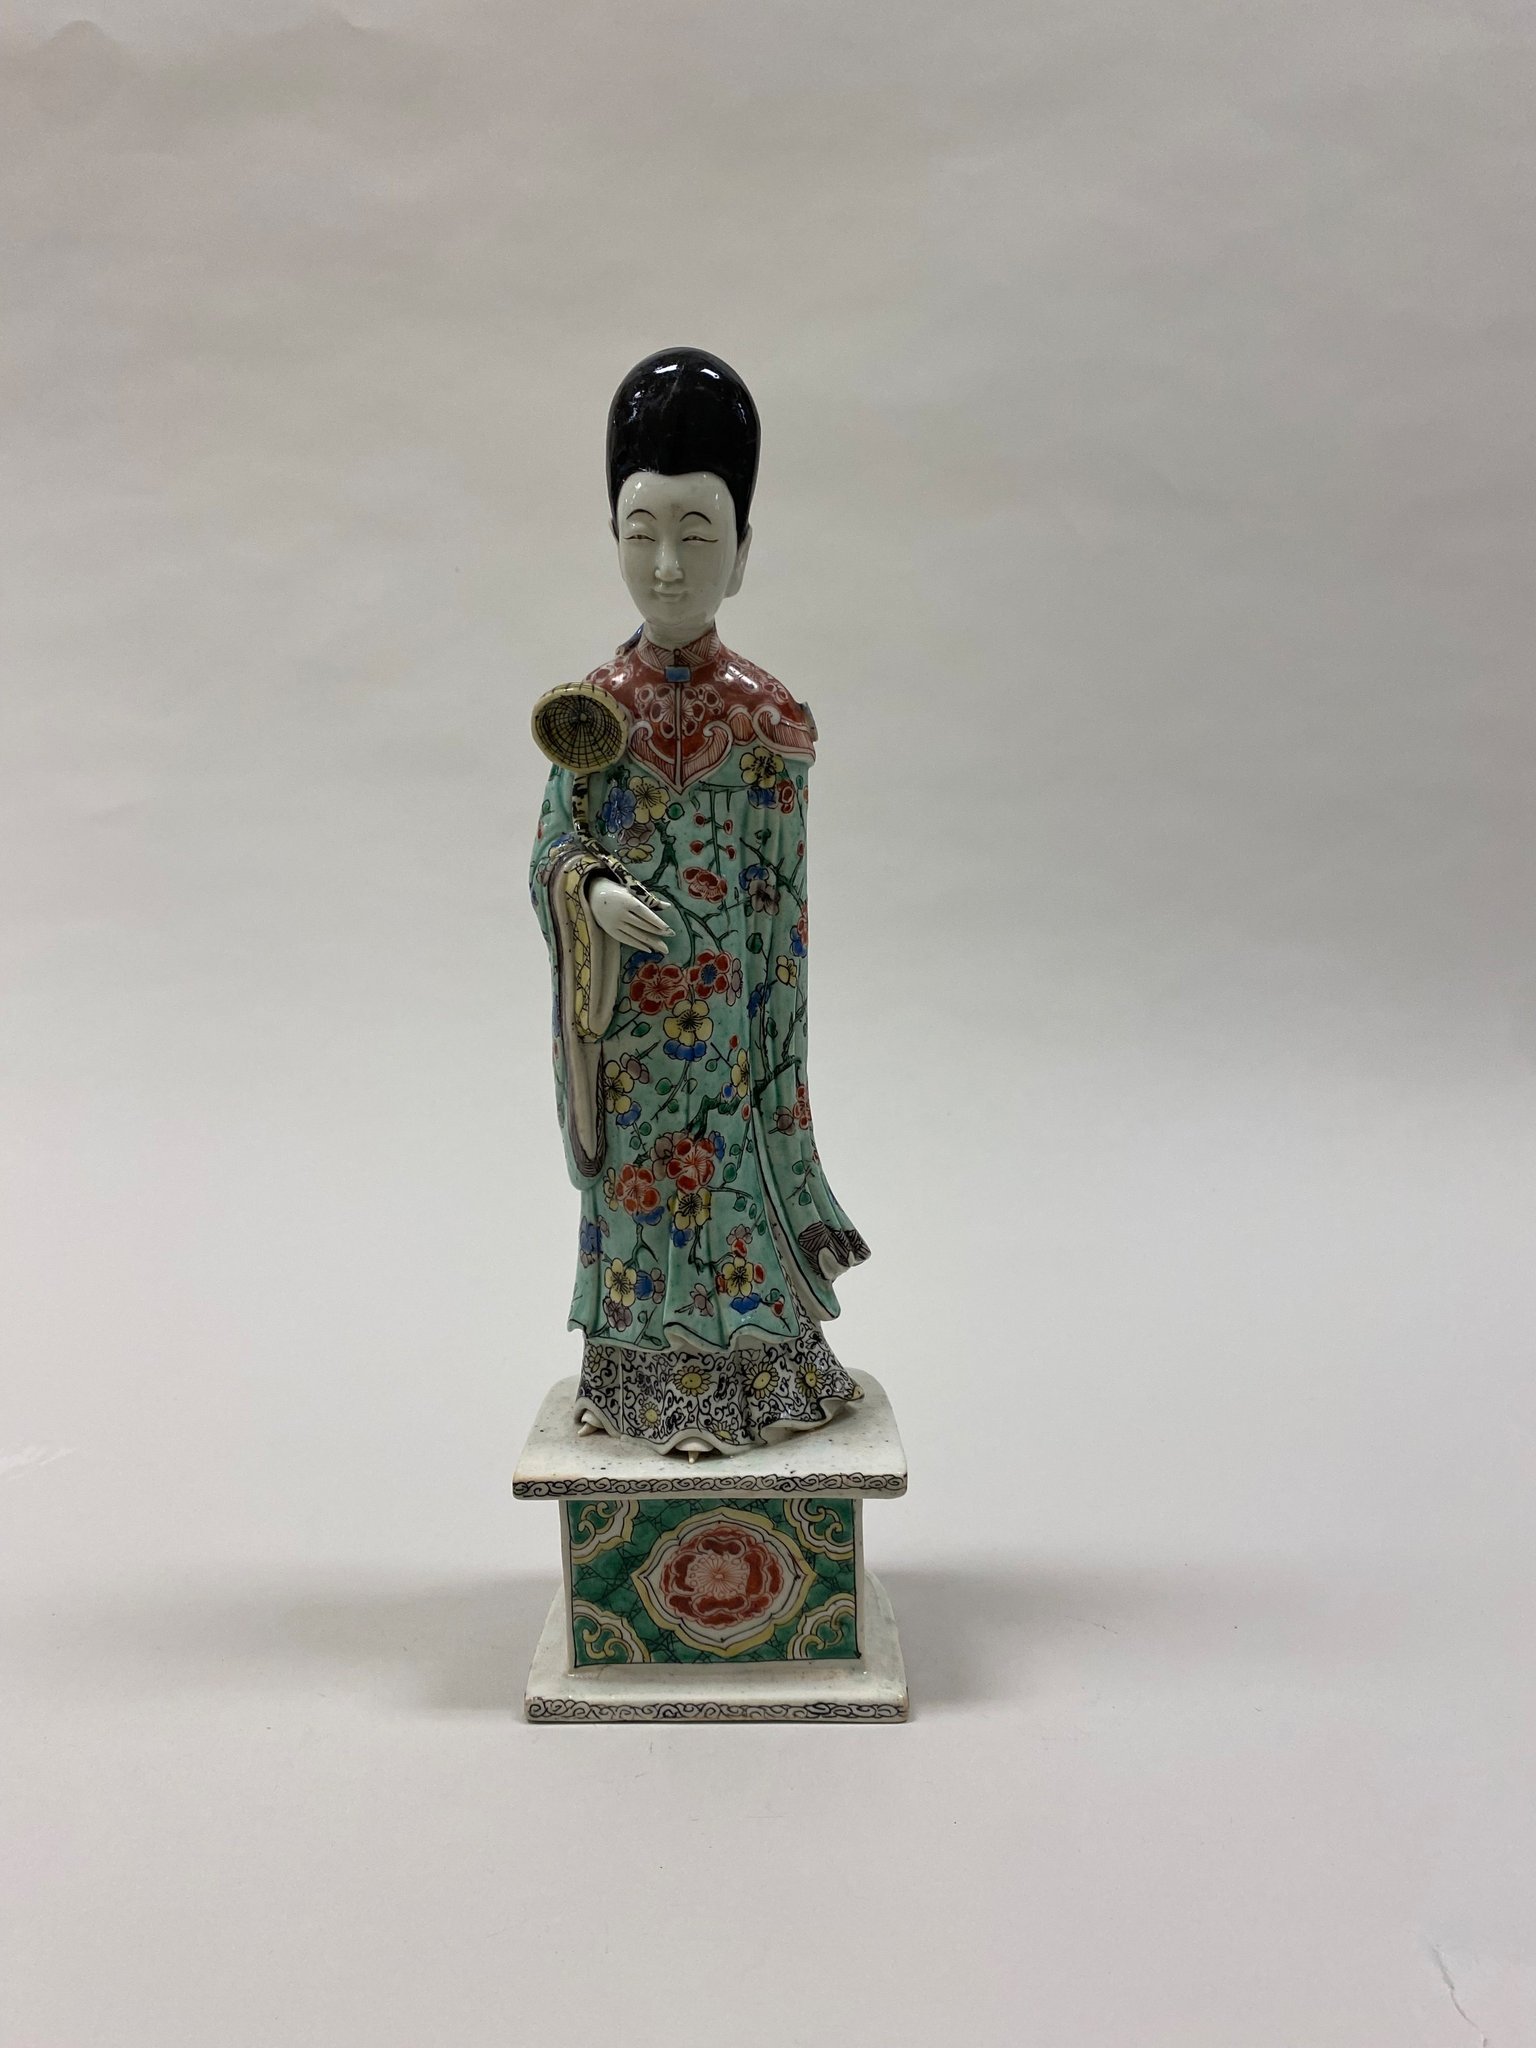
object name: figure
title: Figure of He Xiangu, one of the Eight Immortals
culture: chinese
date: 1801-1900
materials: biscuit, enamel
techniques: polychrome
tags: women